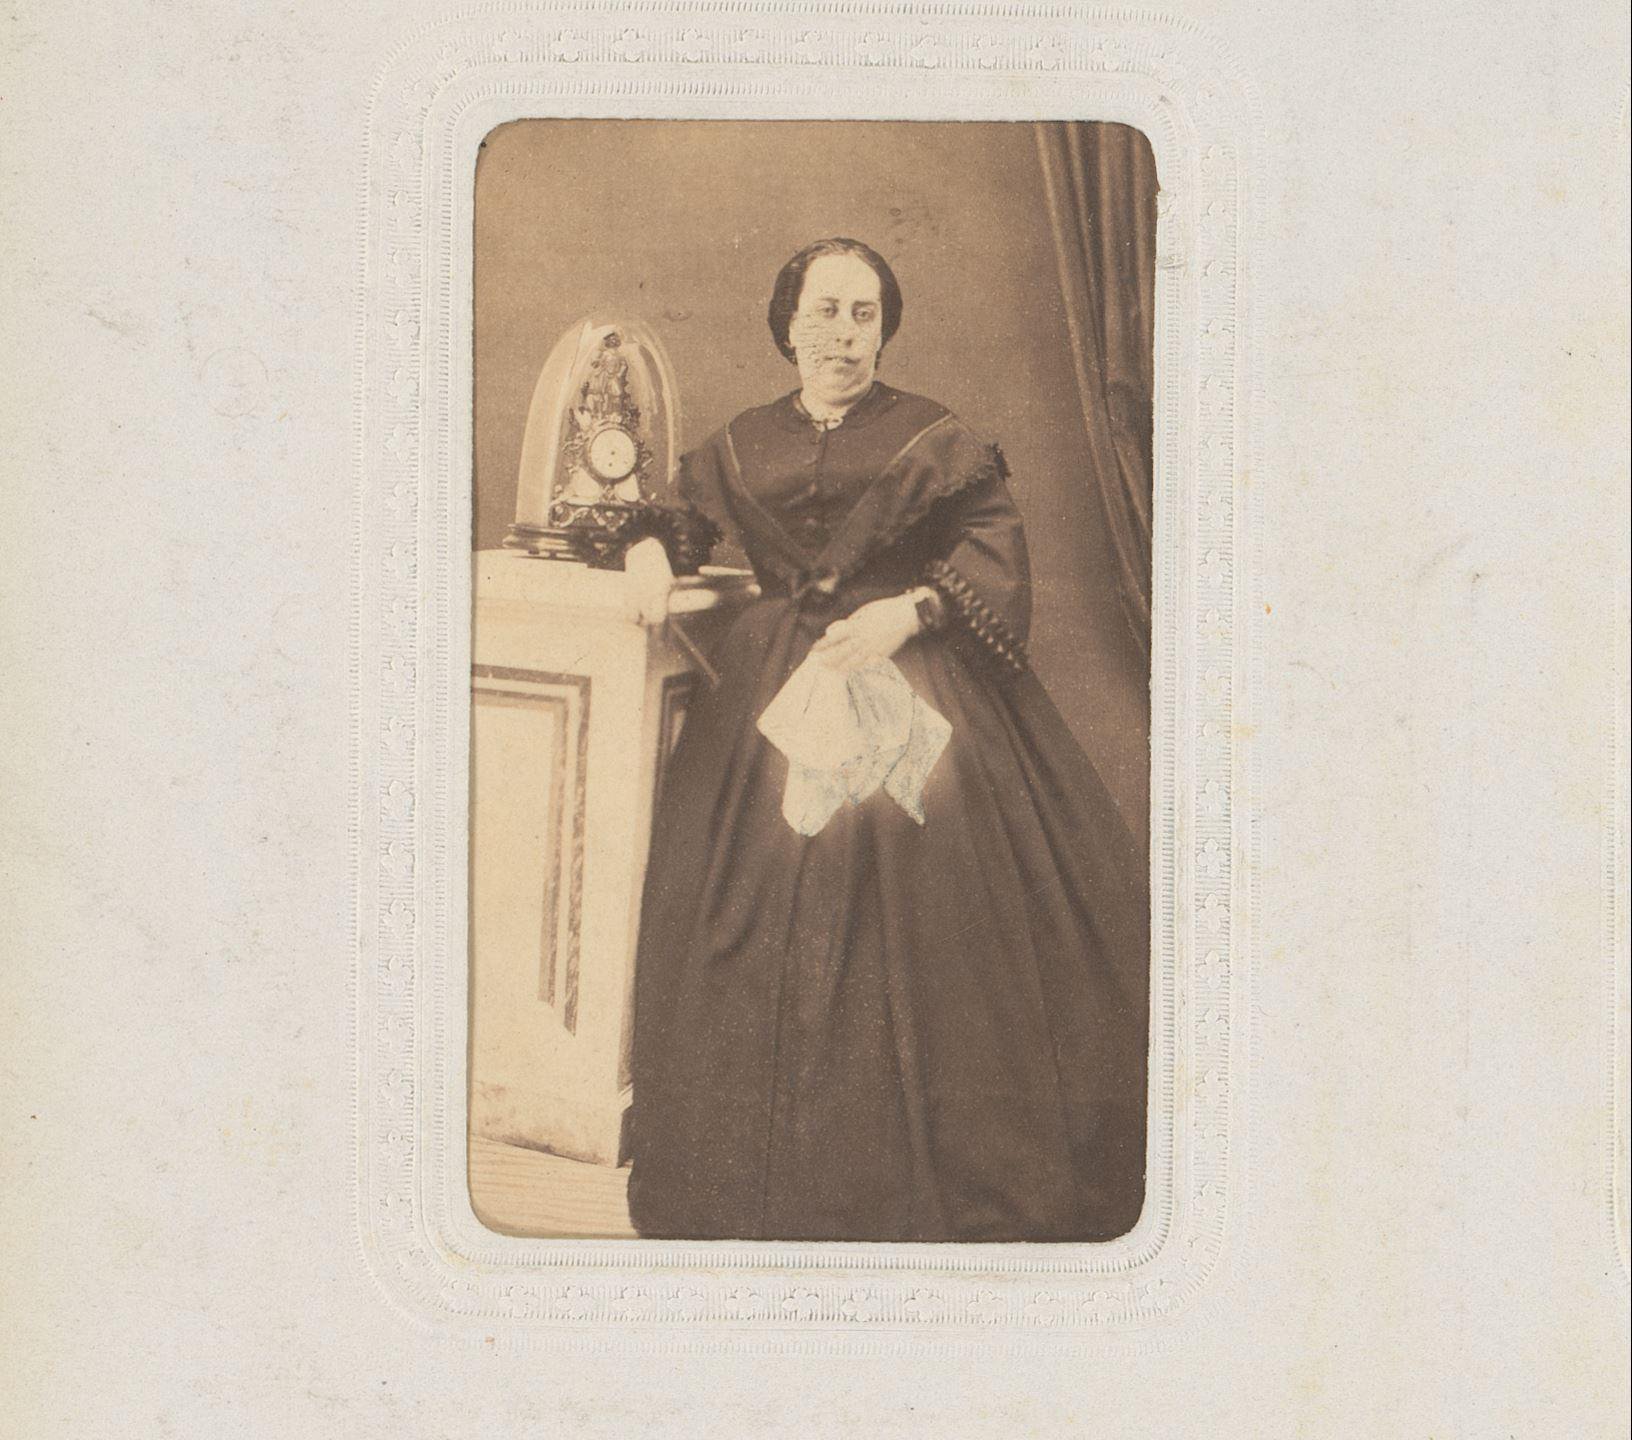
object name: photograph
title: Portret van een vrouw met zakdoek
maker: Anonymous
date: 1860-1890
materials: cardboard, photographic support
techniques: albumen print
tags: historical persons - bb - woman, handkerchief